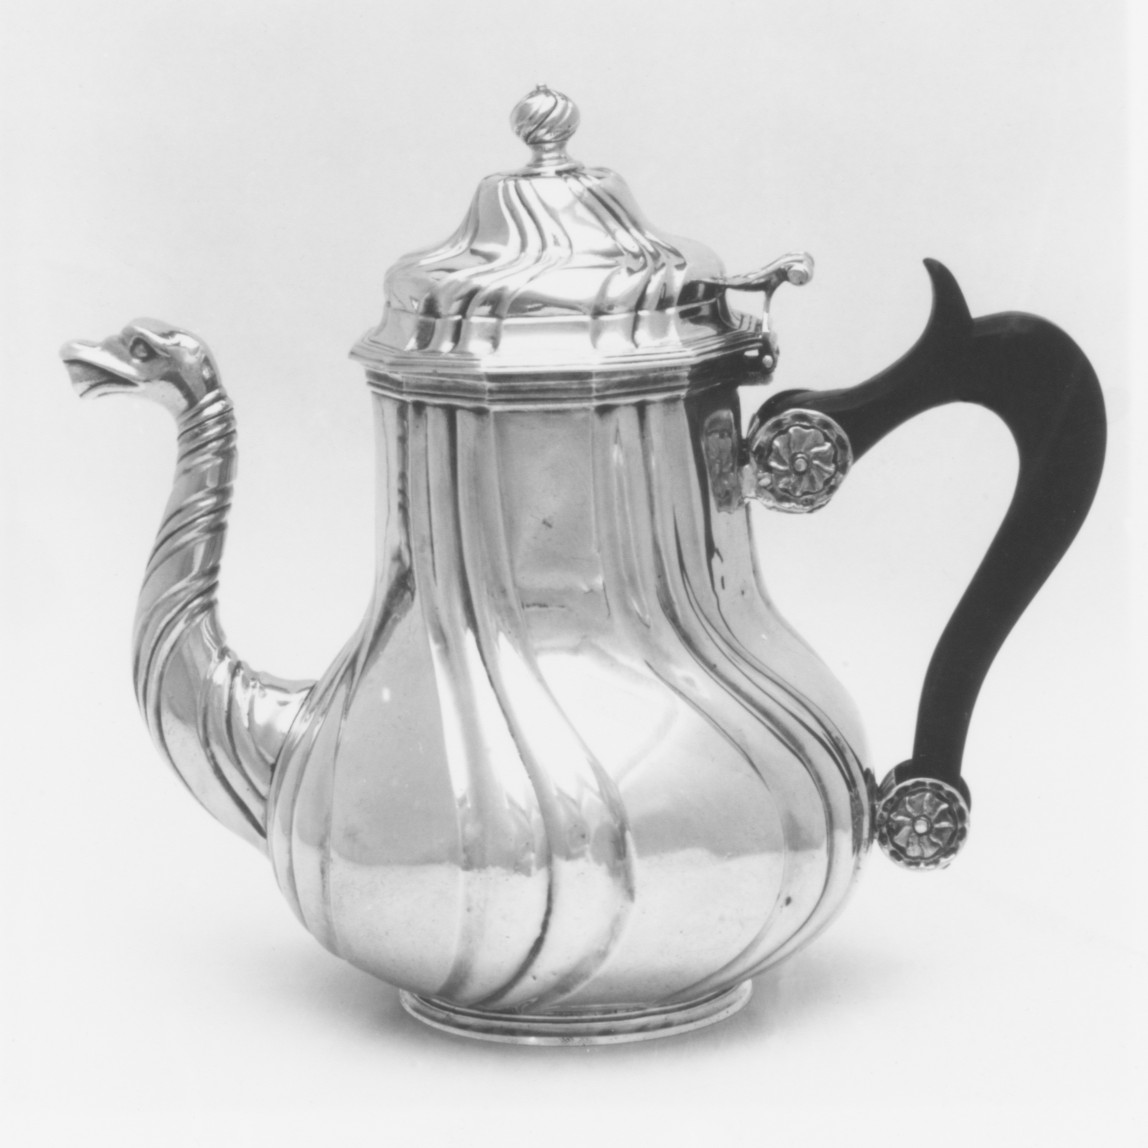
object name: teapot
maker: l.f.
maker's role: maker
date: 1756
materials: wood, silver